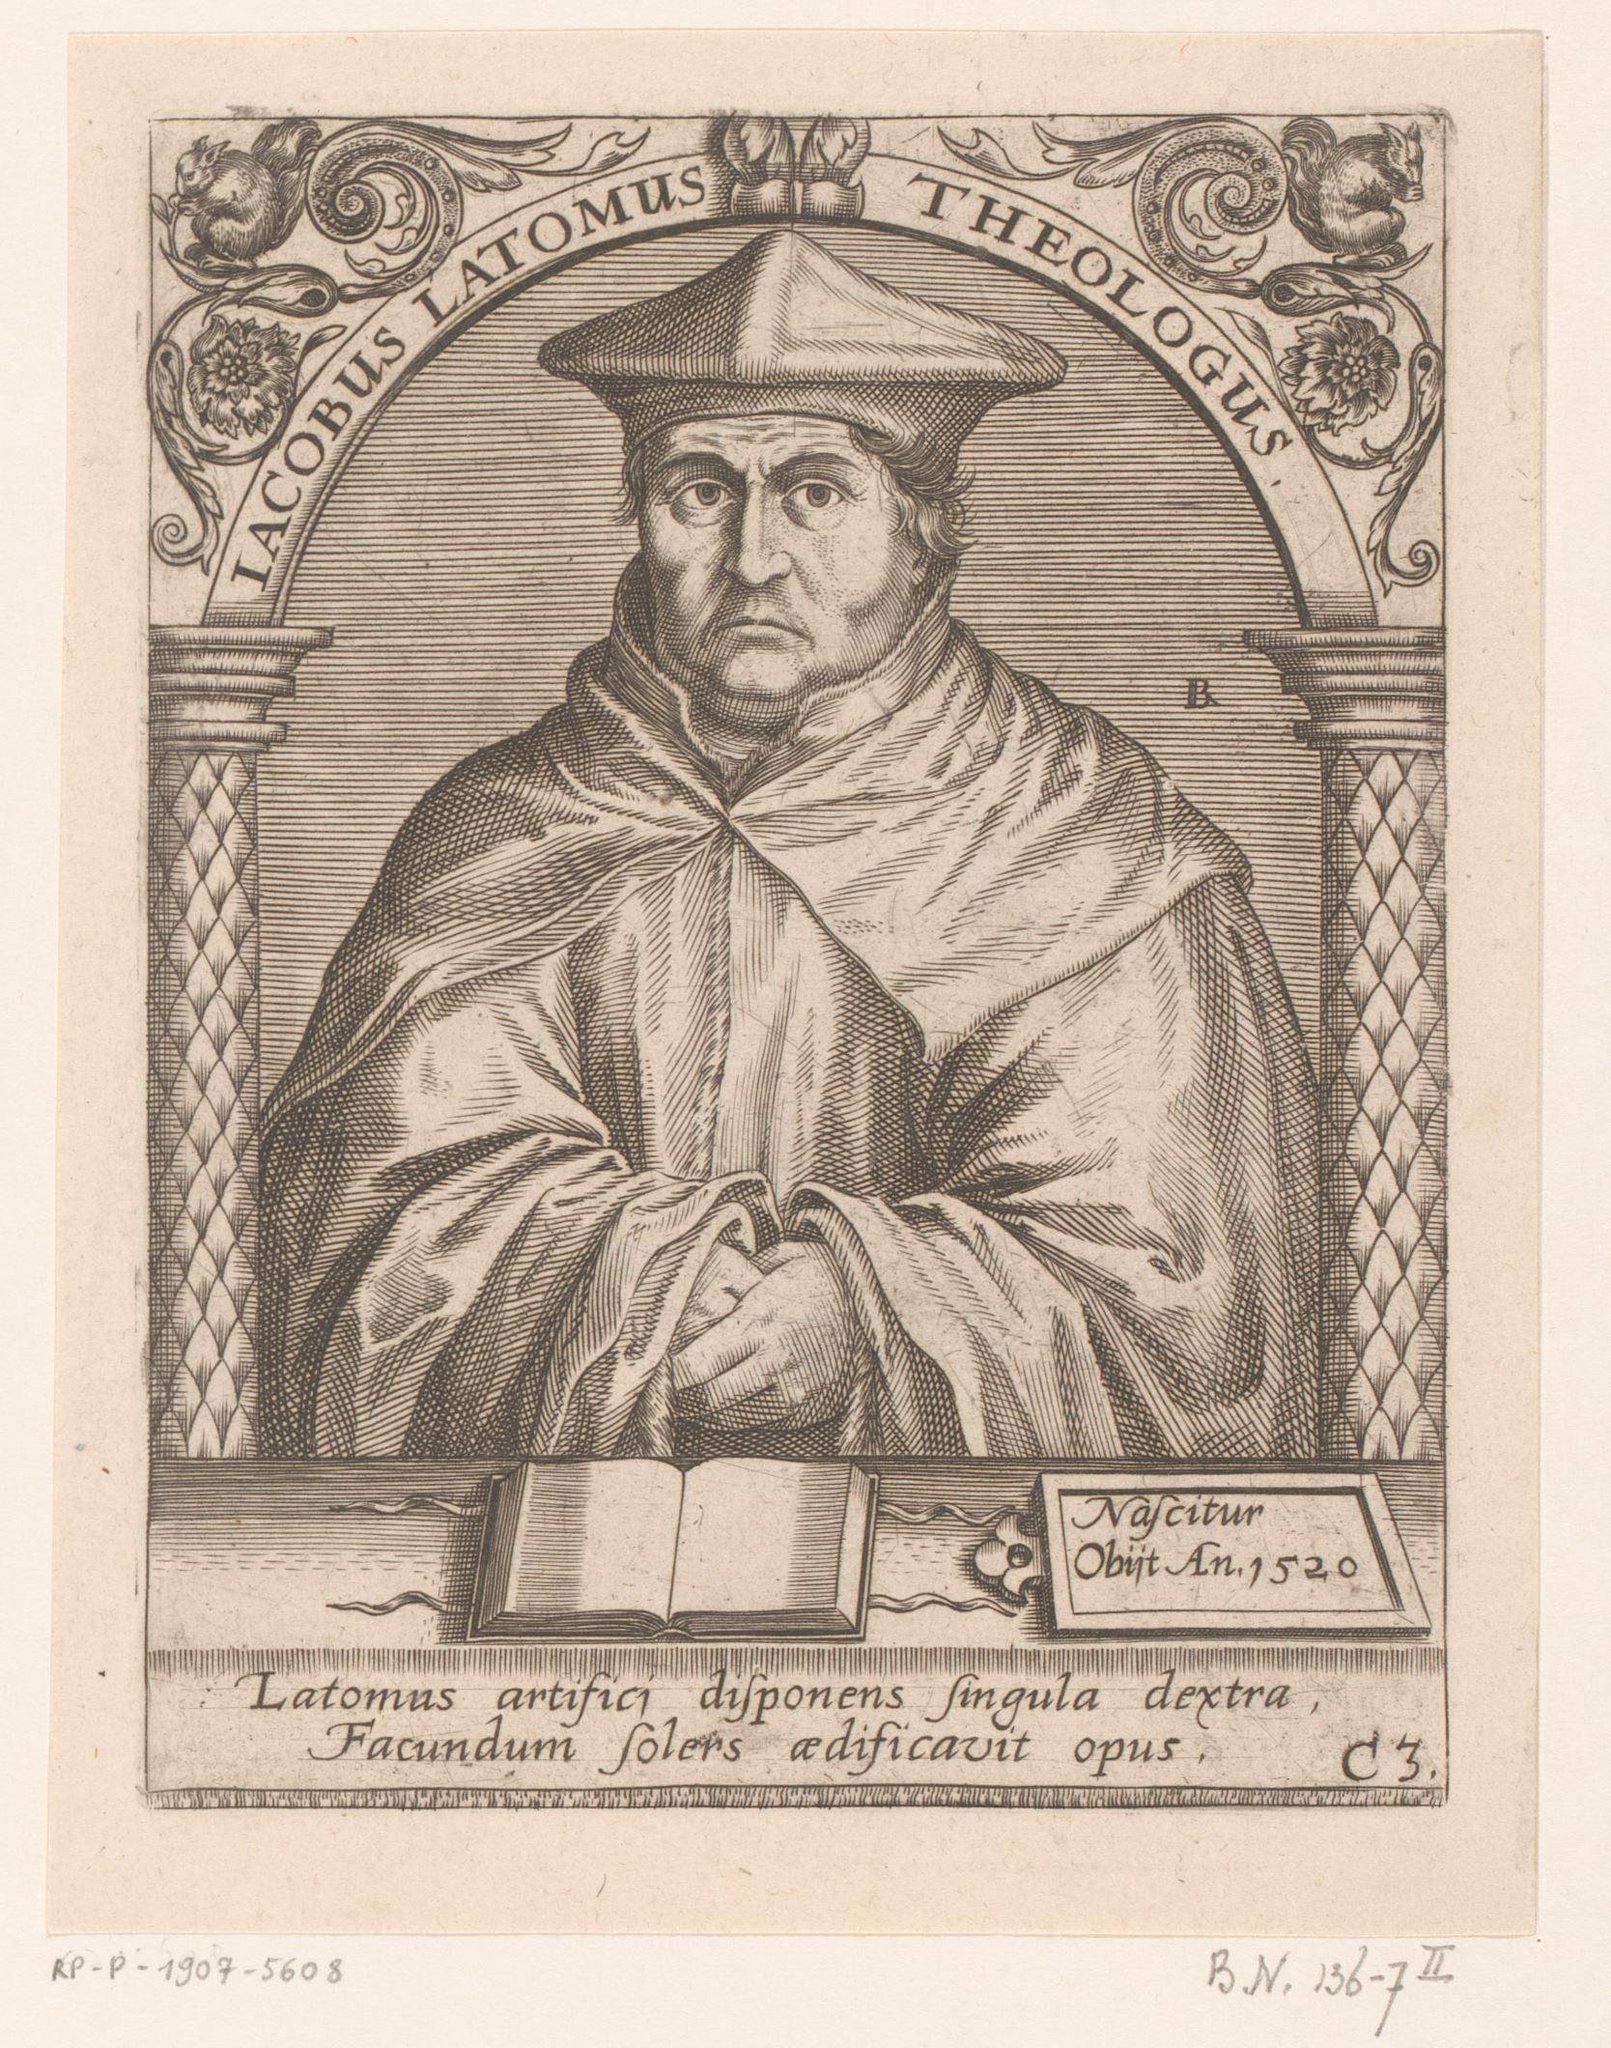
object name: print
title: Jacobus Latomus theologus.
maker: robert boissard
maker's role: print maker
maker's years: 1570-1611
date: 1597-1599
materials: paper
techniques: engraving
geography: france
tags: louvain, rodents: squirrel - ff fabulous animals (sometimes wrongly called 'grotesques'); 'mostri' (ripa), historical persons, book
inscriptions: collector's mark: Lugt 2228